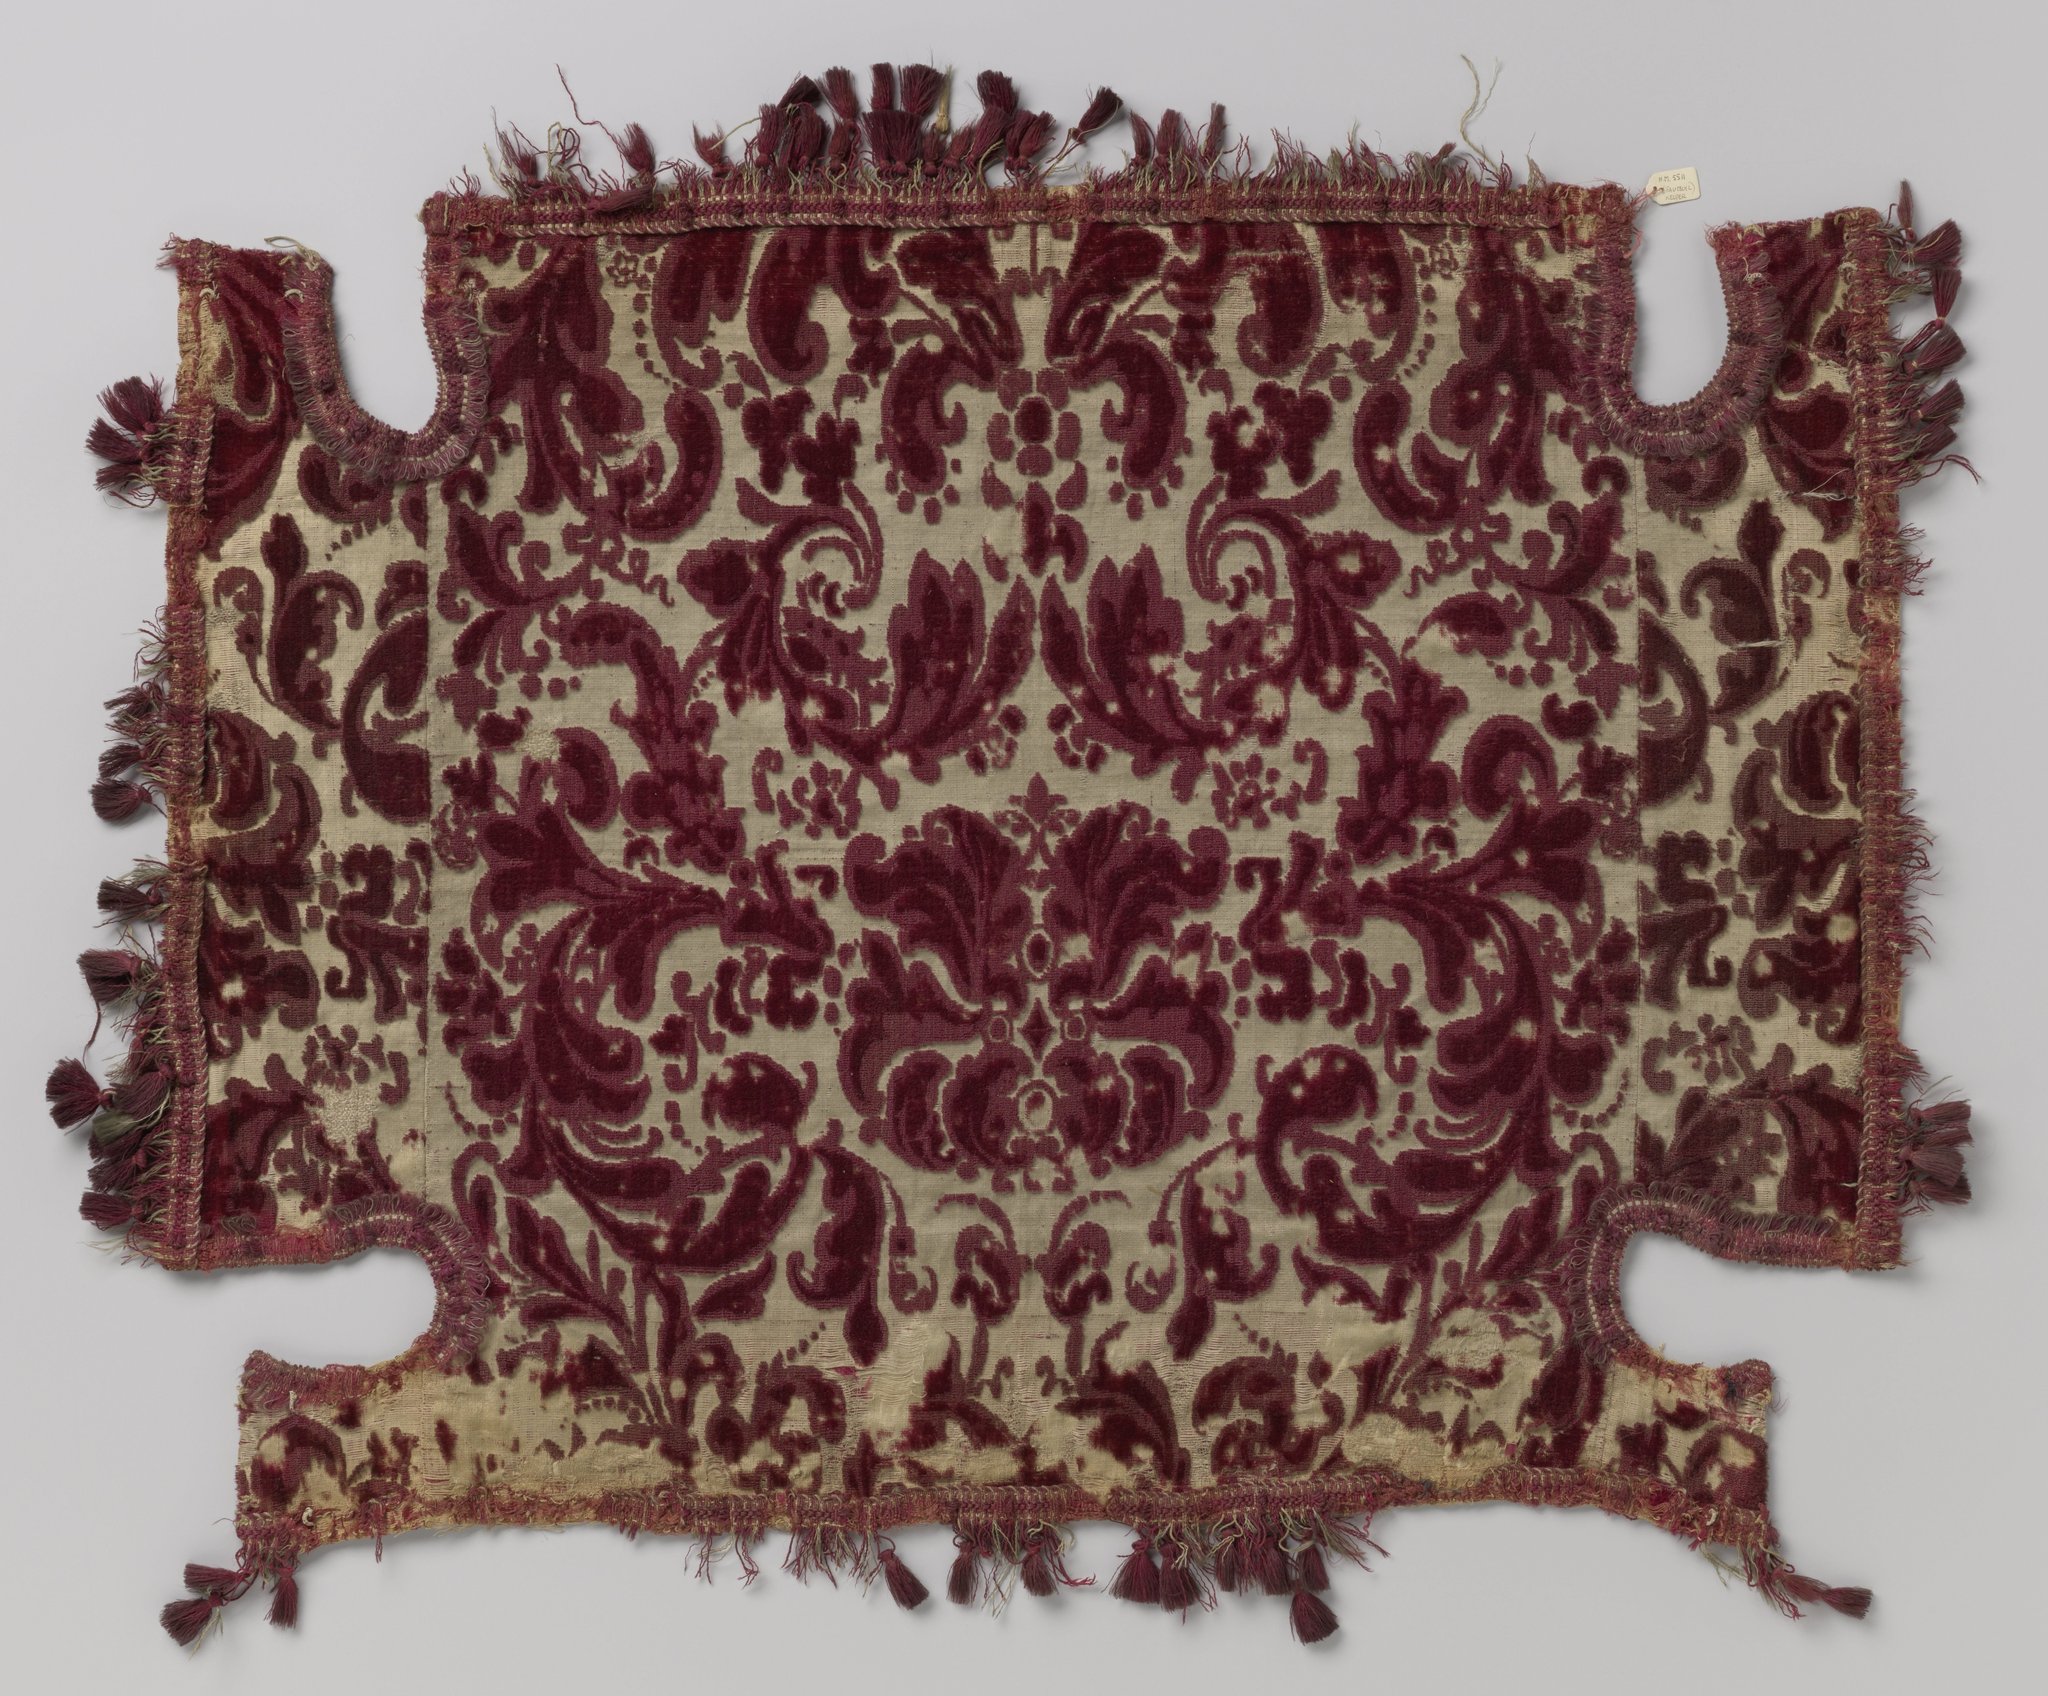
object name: stoelbekleding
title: Stoelbekleding van relieffluweel met floraal patroon in bordeauxrood op naturel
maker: Anonymous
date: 1650-1700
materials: cotton, silk, velvet, wool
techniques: weave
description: Bekleding voor een stoelzitting van relieffluweel met floraal patroon. Het patroon bestaat uit bordeauxrode acanthusbladeren op een naturelkleurige grond. De randen zijn versierd met passement met franjes in rood.